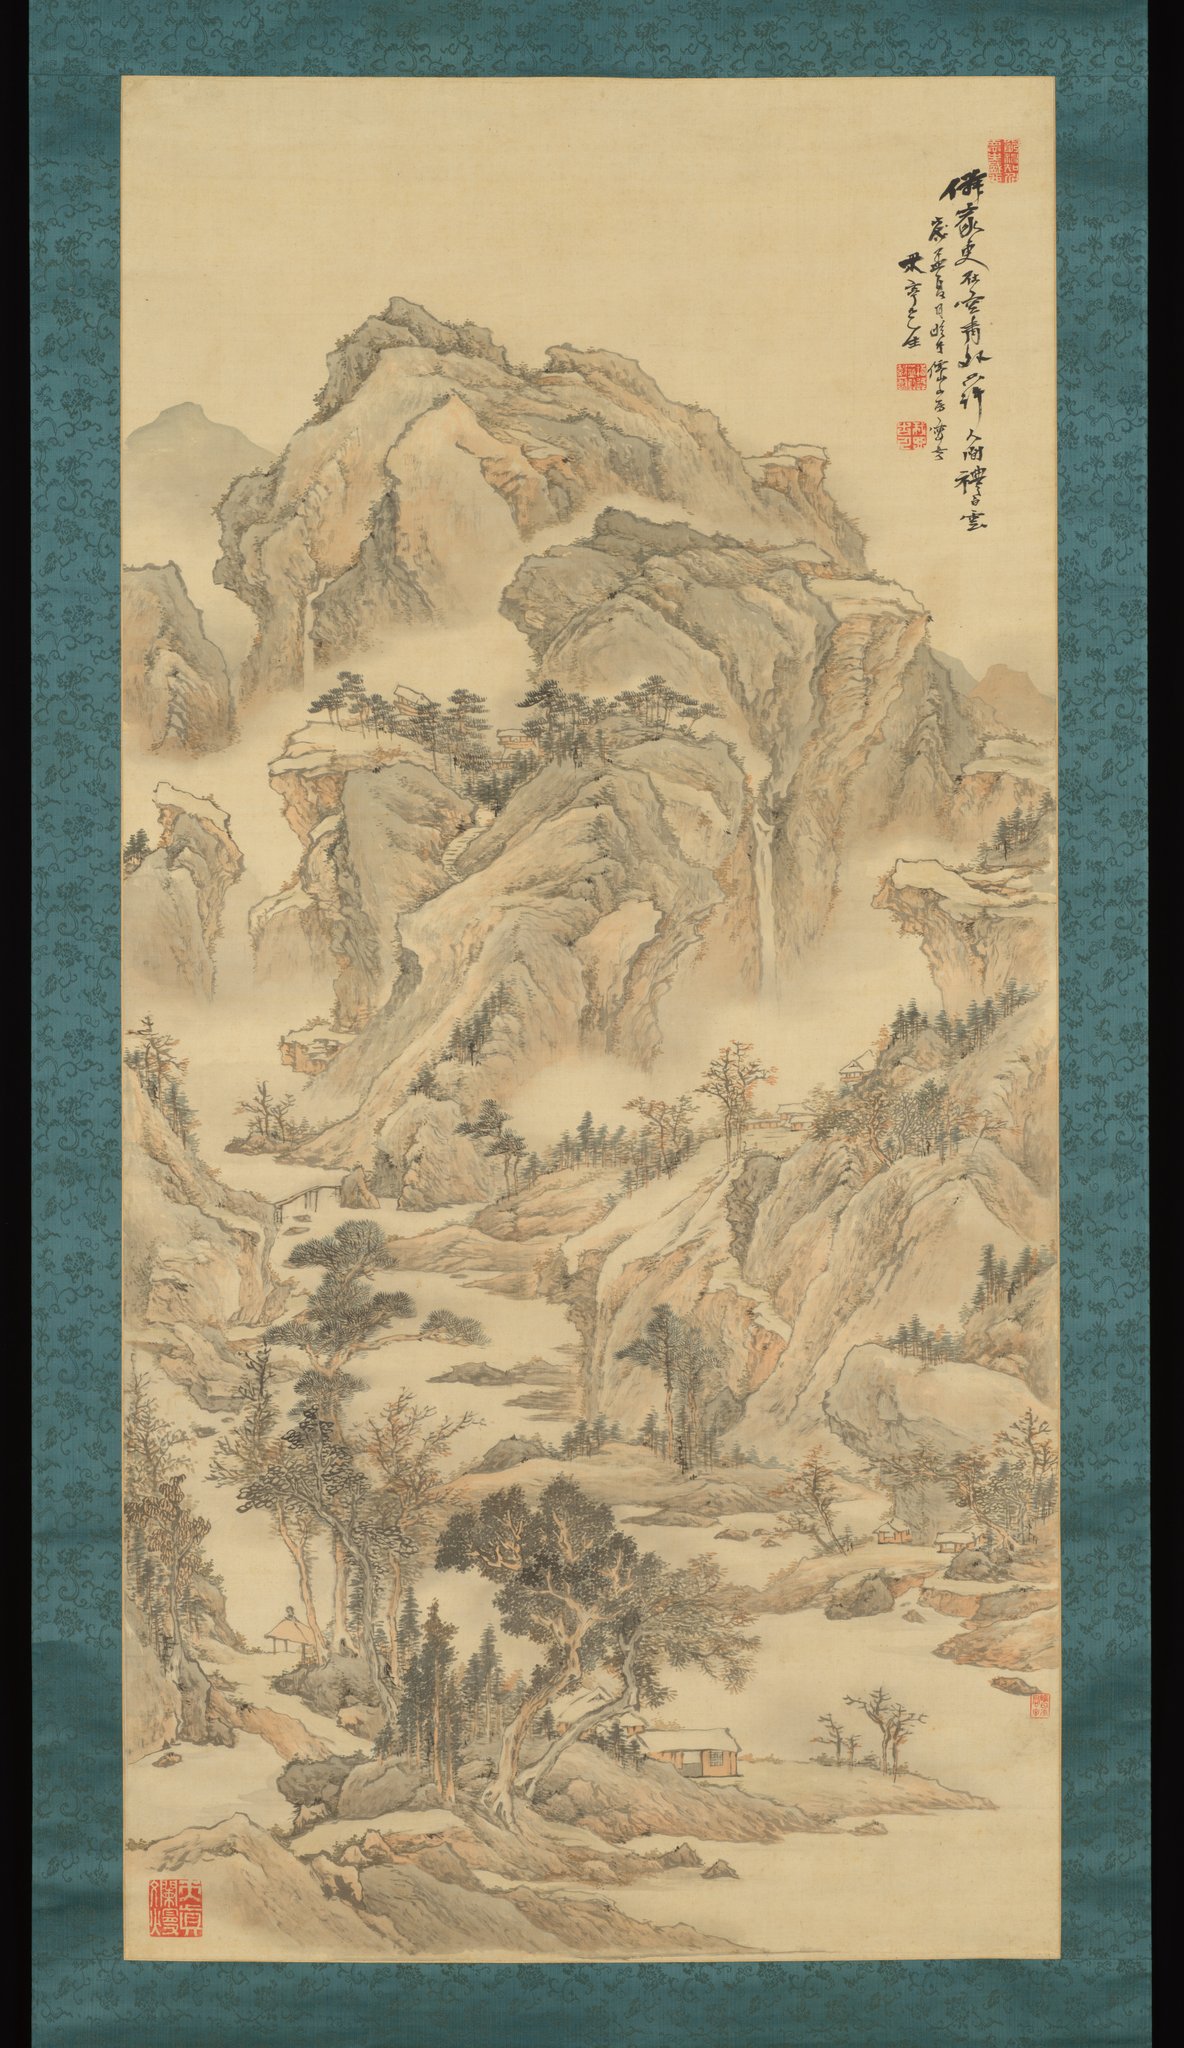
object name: hanging scroll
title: Autumn in Myriad Valleys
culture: japanese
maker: kodama katei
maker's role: artist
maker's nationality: japanese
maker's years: 1841-1913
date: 1898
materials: ink, silk